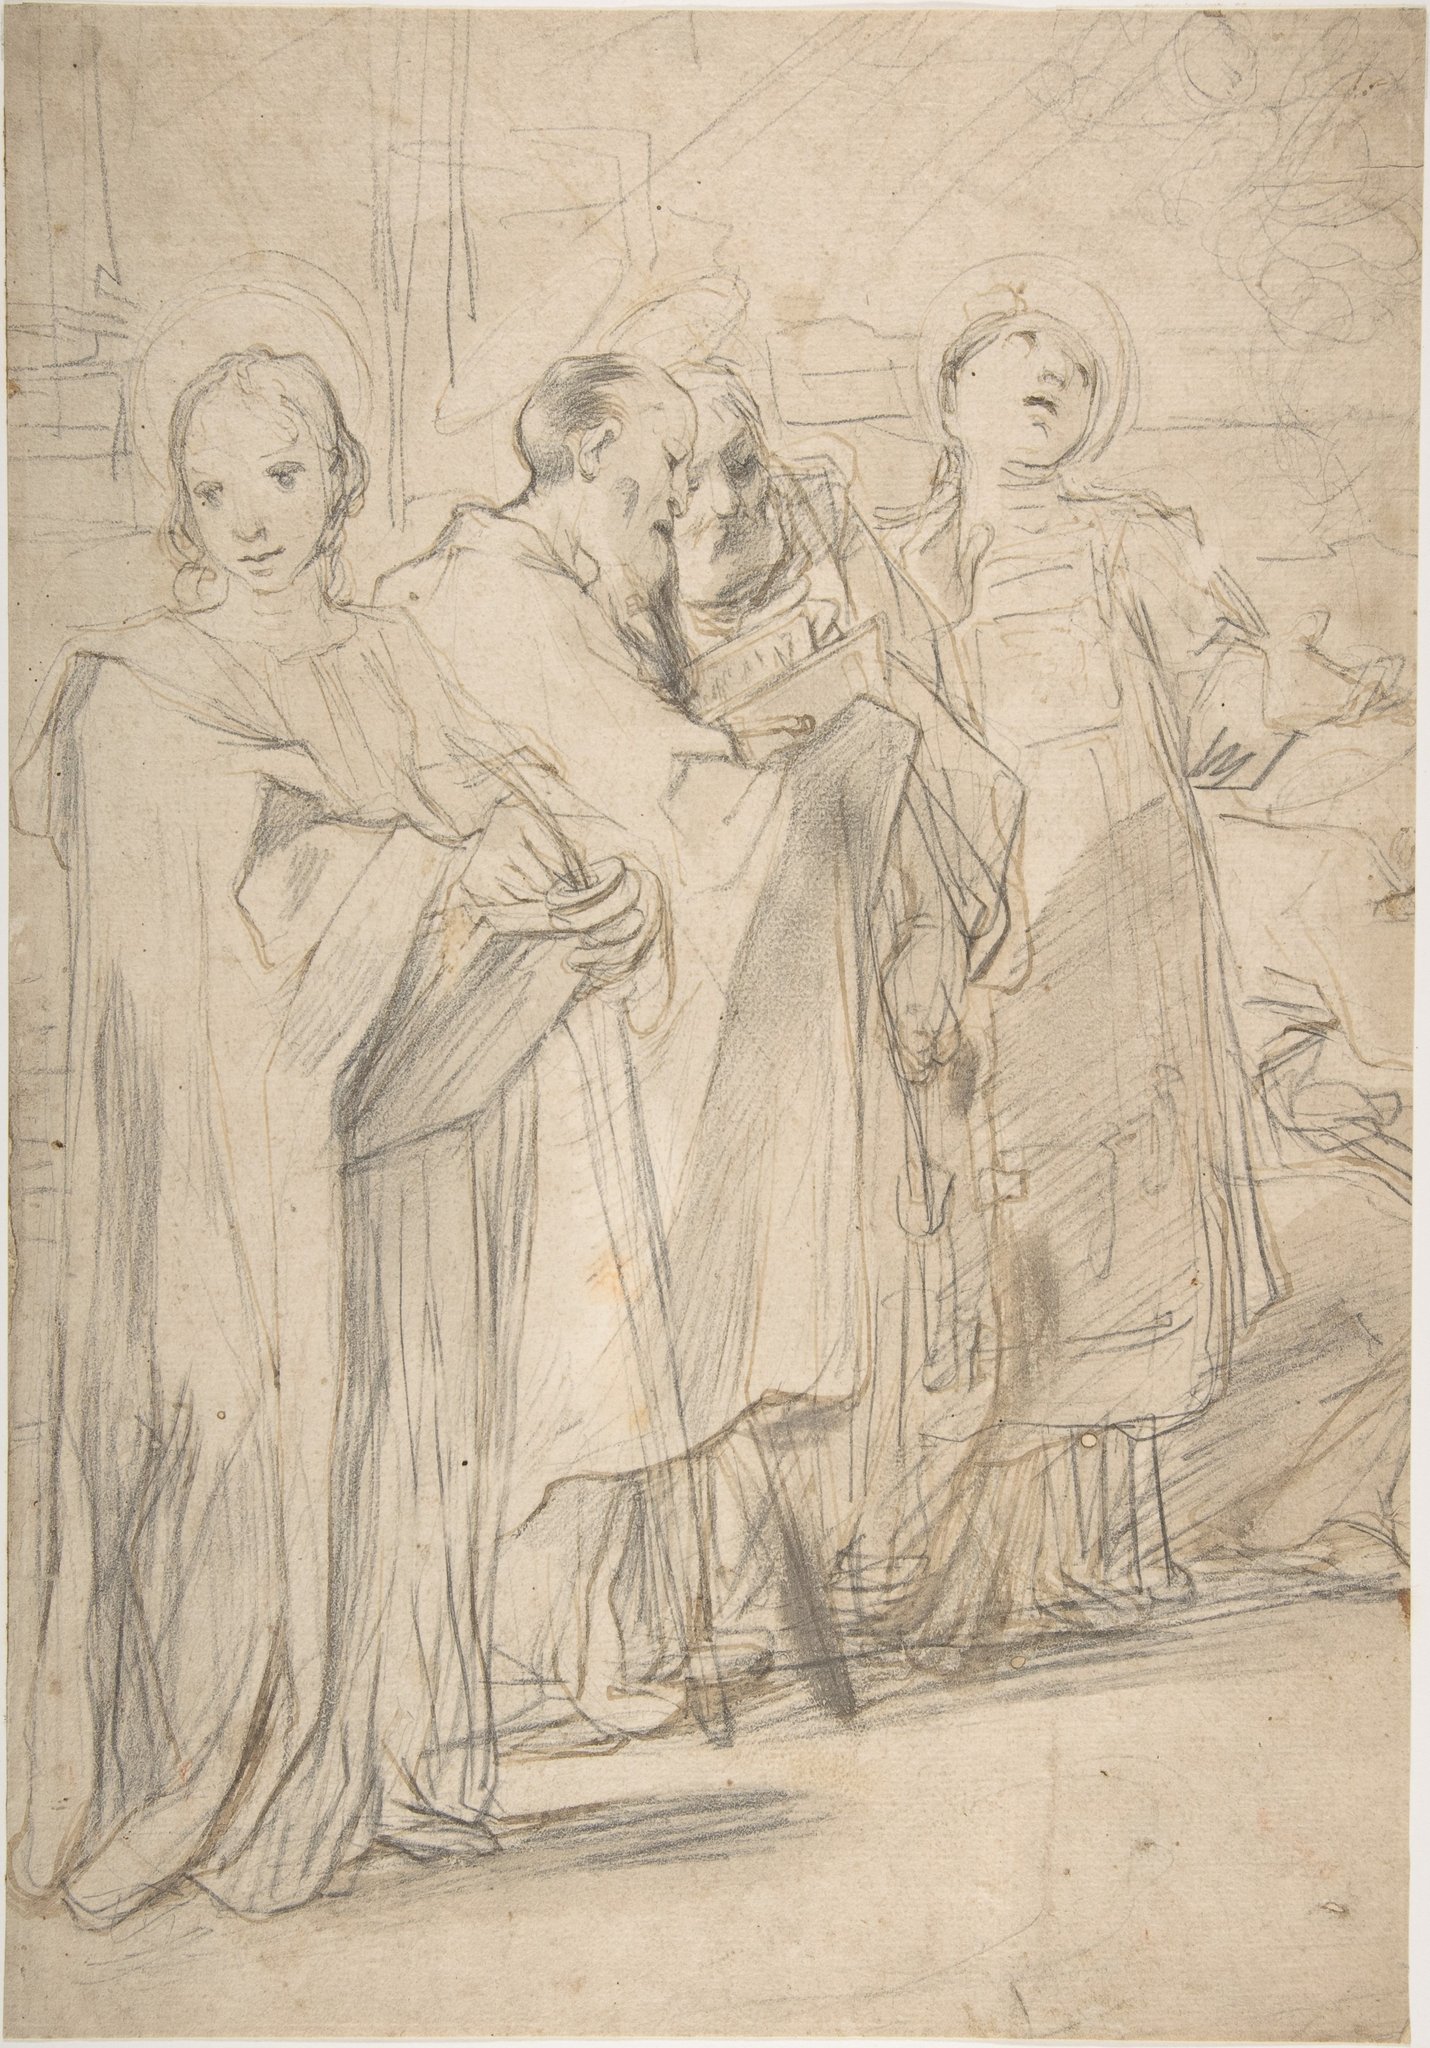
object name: drawing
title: Saints John the Evangelist, Paul, Peter, and Stephen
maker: ferraù fenzoni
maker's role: artist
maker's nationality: italian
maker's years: 1562-1645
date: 1590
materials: chalk, ink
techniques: brush, pen, wash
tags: saint john the evangelist,saint paul,saint peter